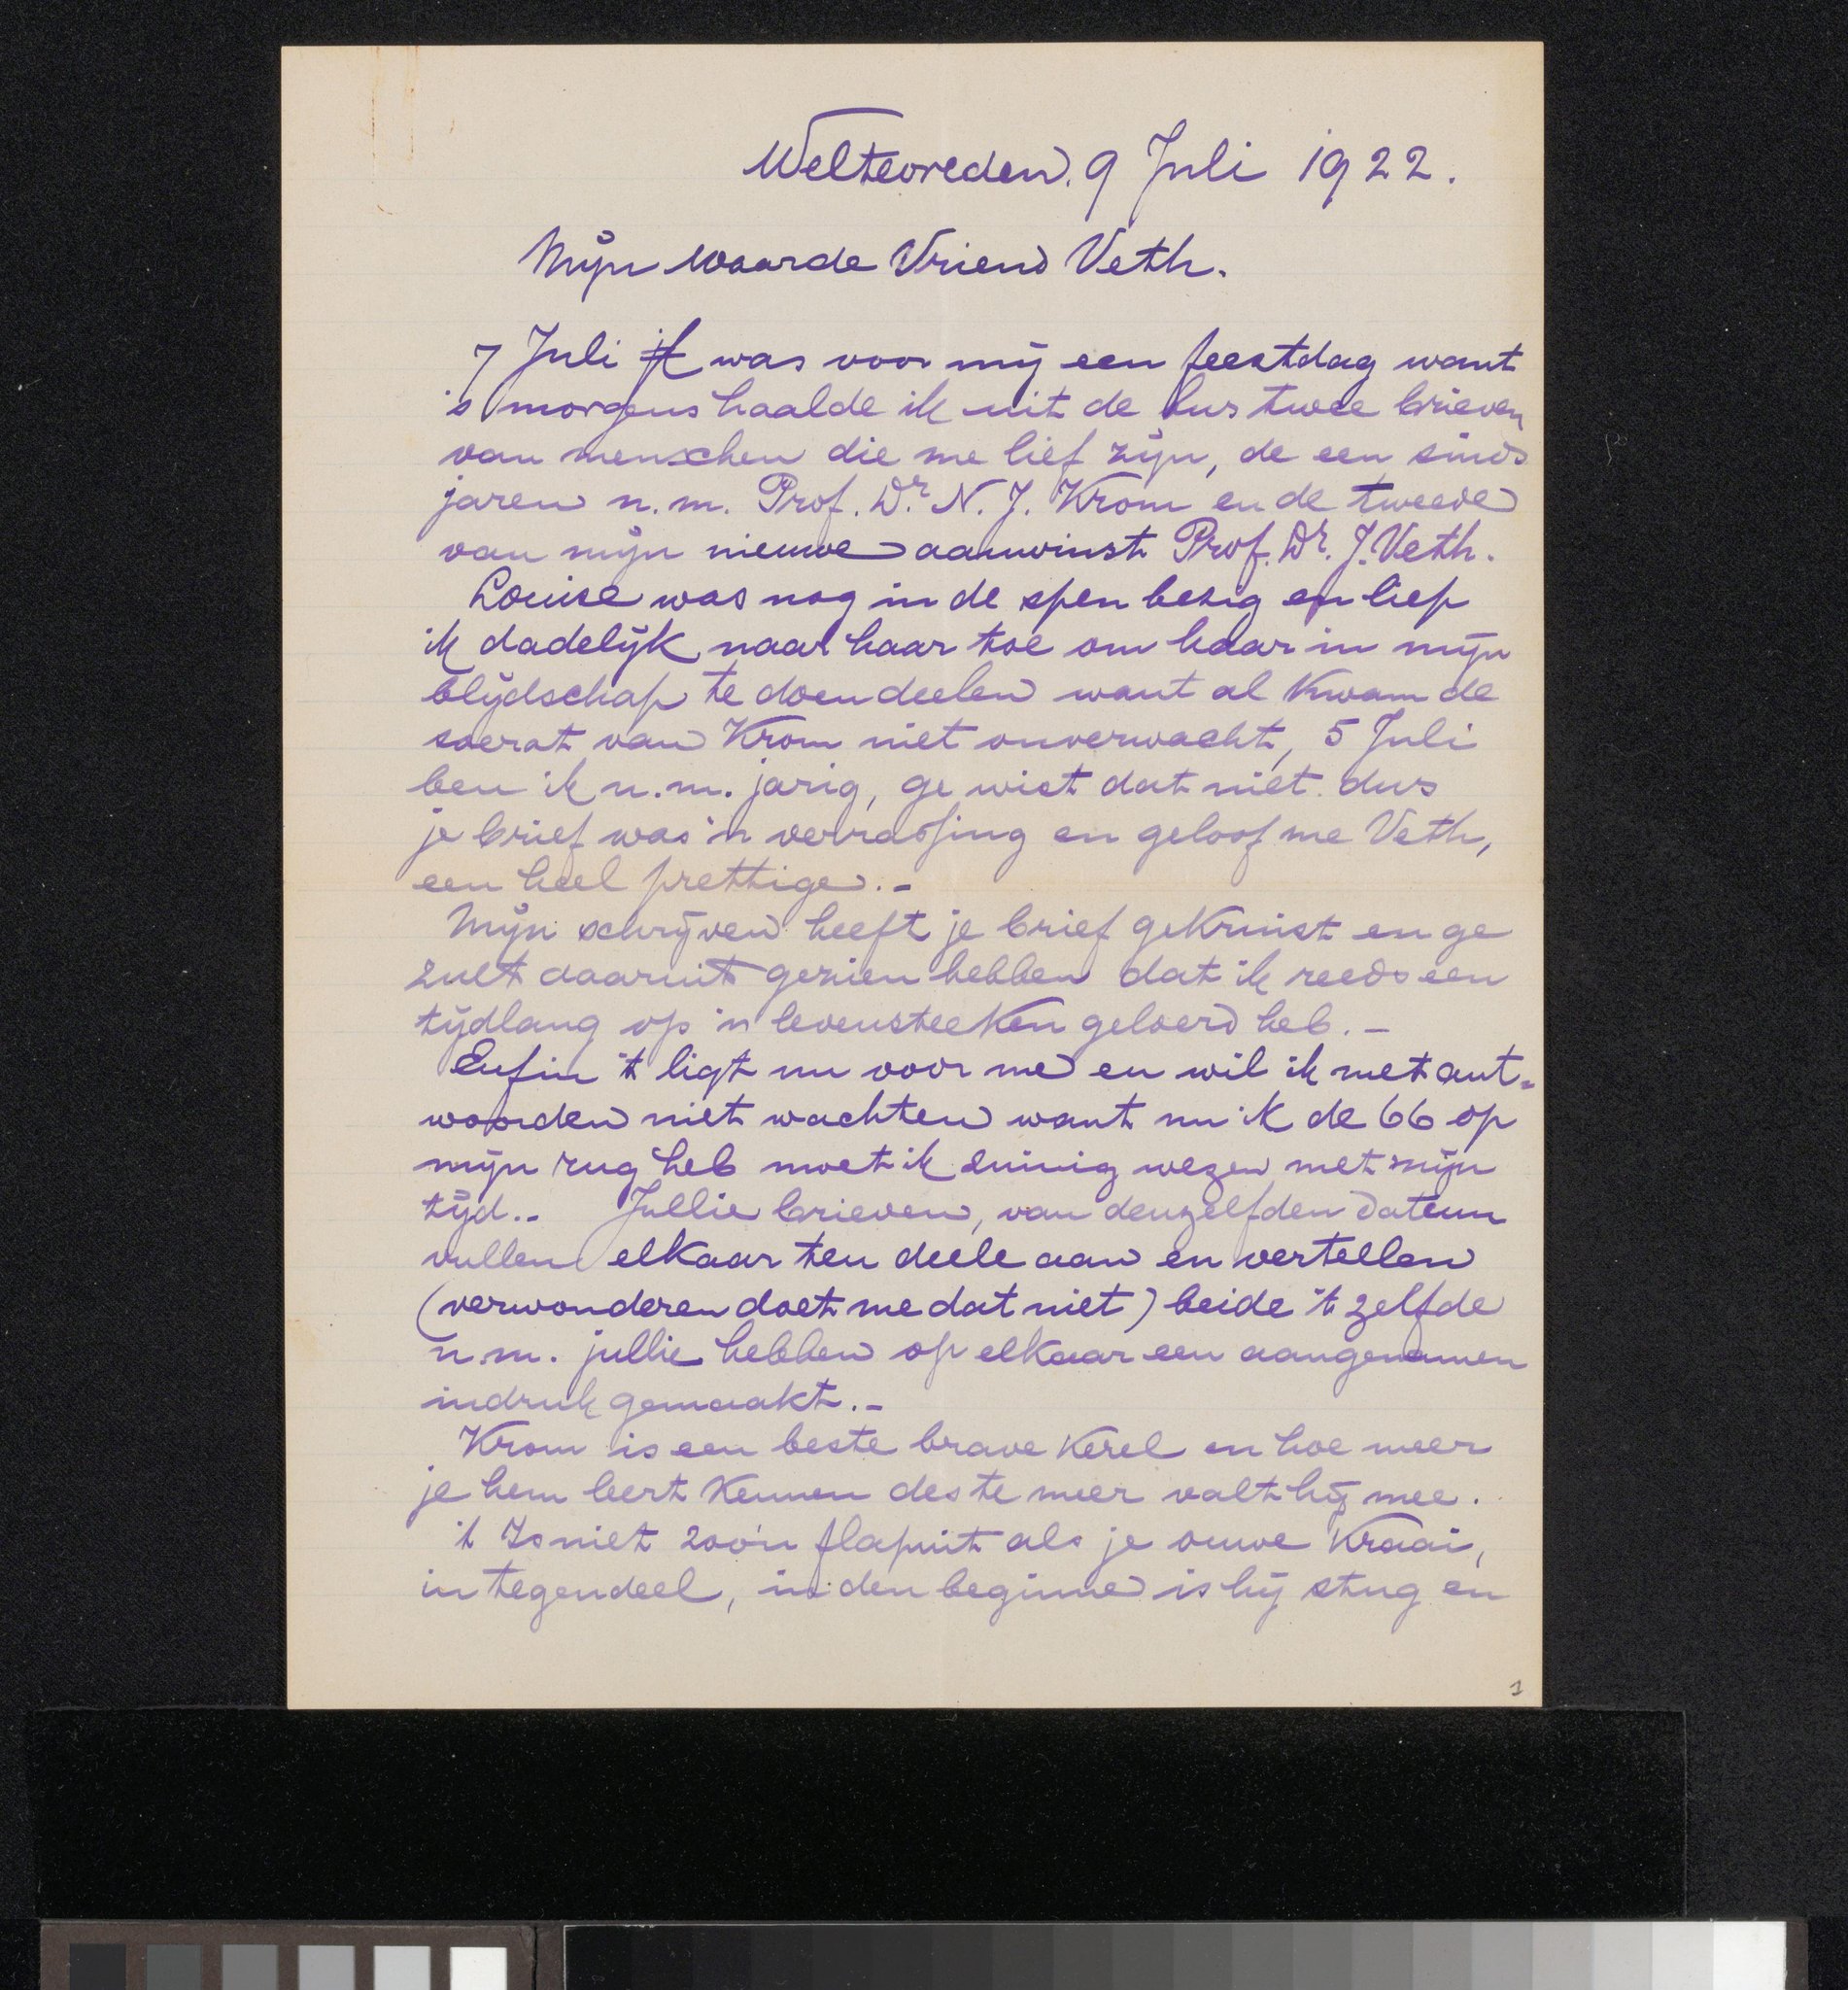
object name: letter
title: Brief aan Jan Veth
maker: jean pierre moquette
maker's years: 1856-1927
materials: ink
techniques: pen, writing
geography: weltevreden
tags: den bosch, leiden, engineer, dordrecht, amsterdam, painter, draughtsman, designer, jan veth, gerret pieter rouffaer, historical persons (portraits and scenes from the life), java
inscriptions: collector's mark: ‘RPK’